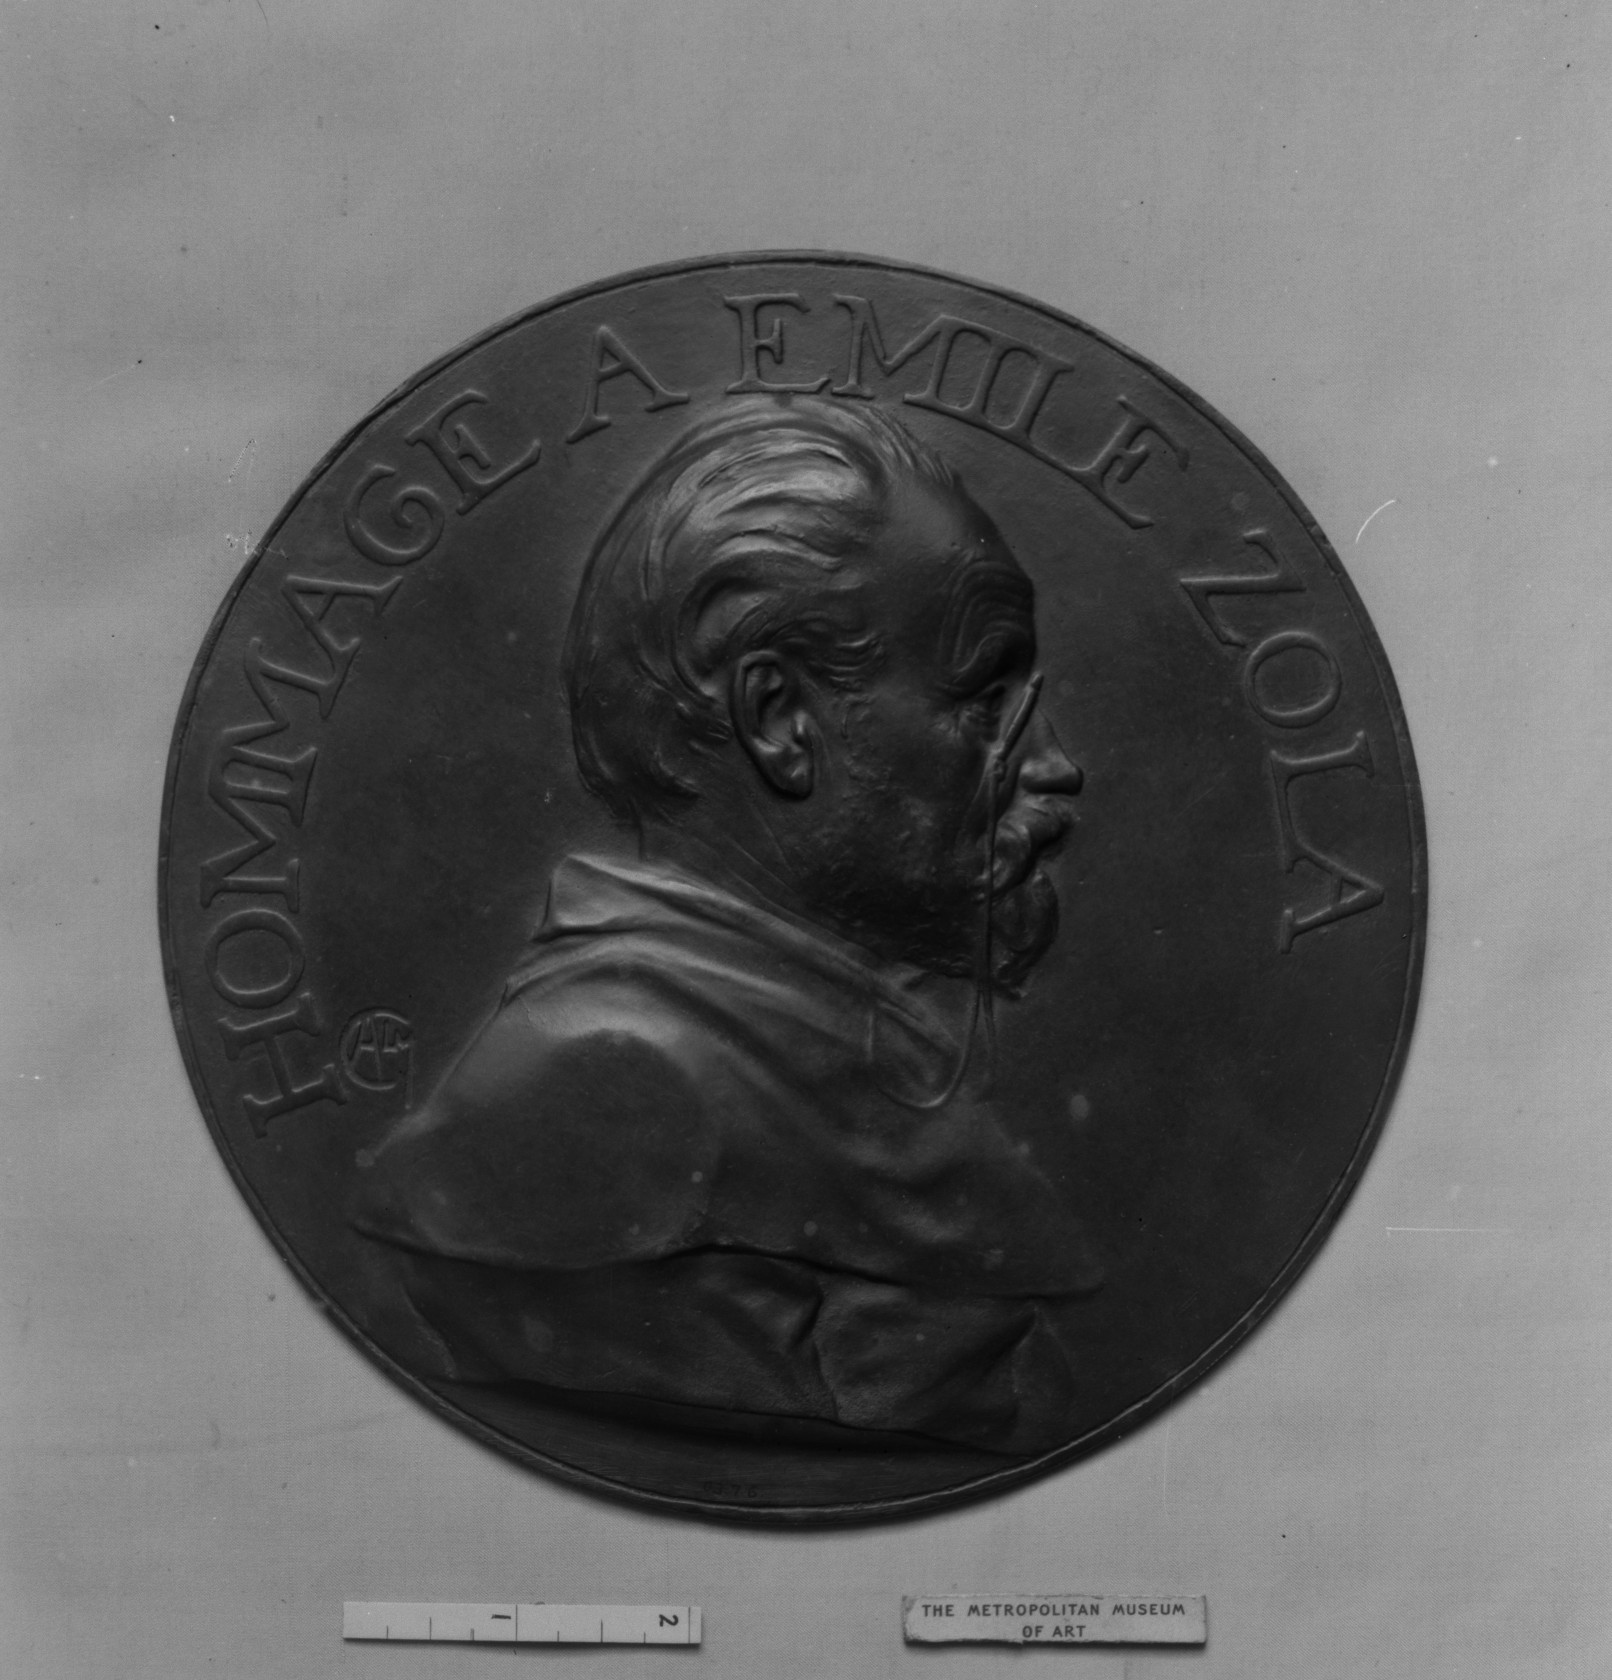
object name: medallion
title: Honoring Émile Zola (1840–1902), French Novelist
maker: alexandre-louis-marie charpentier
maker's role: artist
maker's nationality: french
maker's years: 1856-1909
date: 1898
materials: bronze, patina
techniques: casting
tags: men,profiles